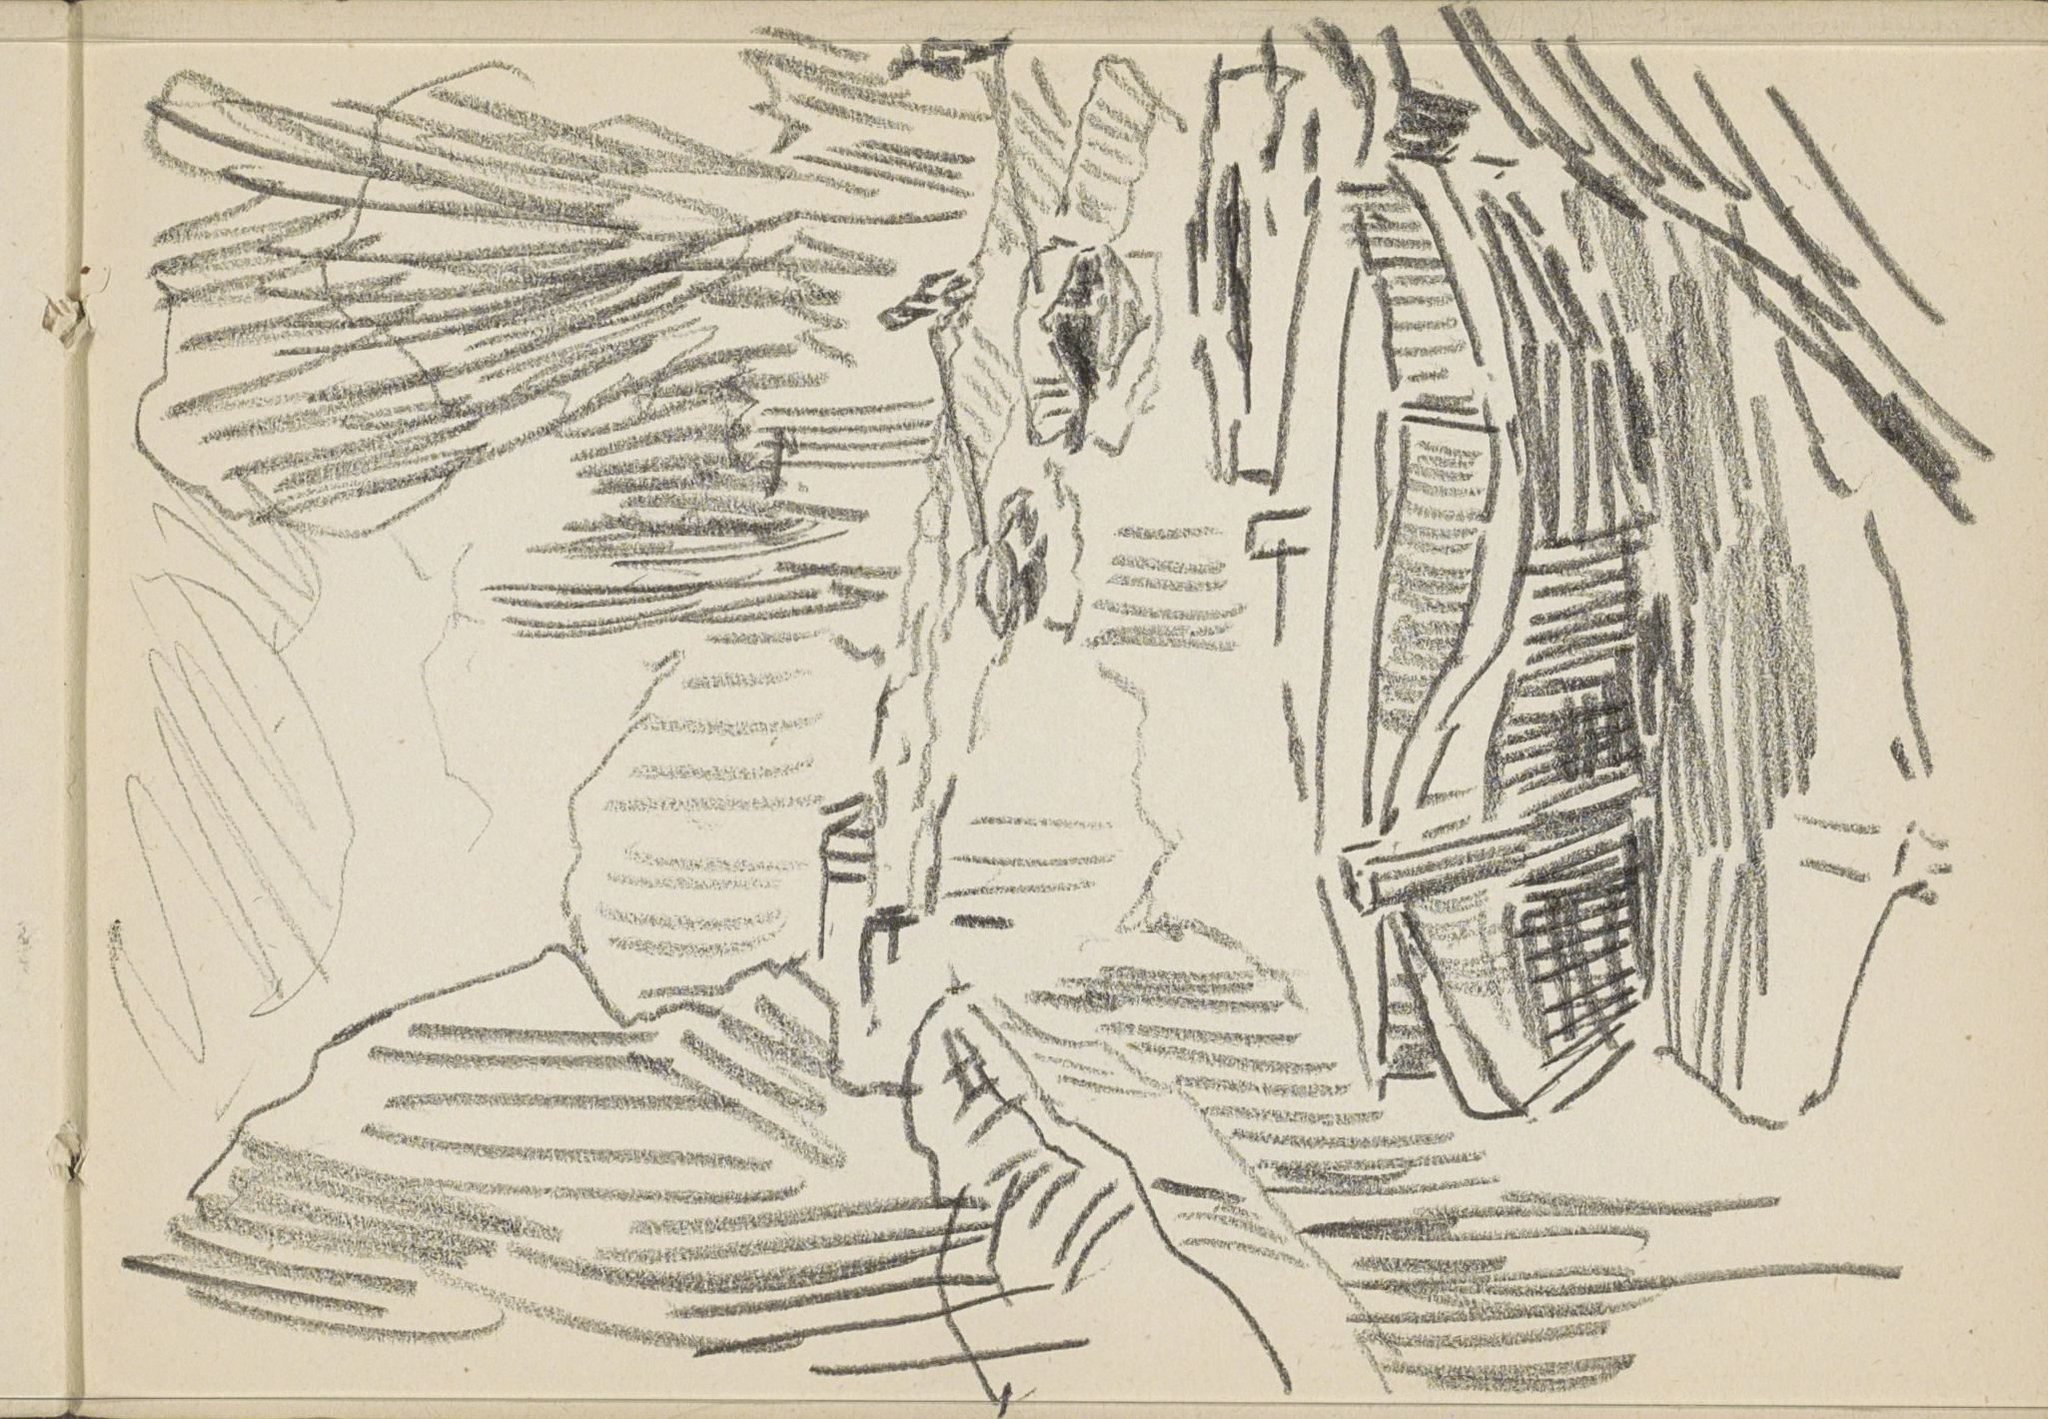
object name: sketchbook leaf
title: Aangemeerde boten op een vaart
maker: alexander shilling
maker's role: draughtsman, print maker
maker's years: 1859-1937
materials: chalk, paper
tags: landscapes with waters, waterscapes, seascapes (in the temperate zone), boat propelled by man or animal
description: Blad 14 recto uit een schetsboek met 30 bladen.